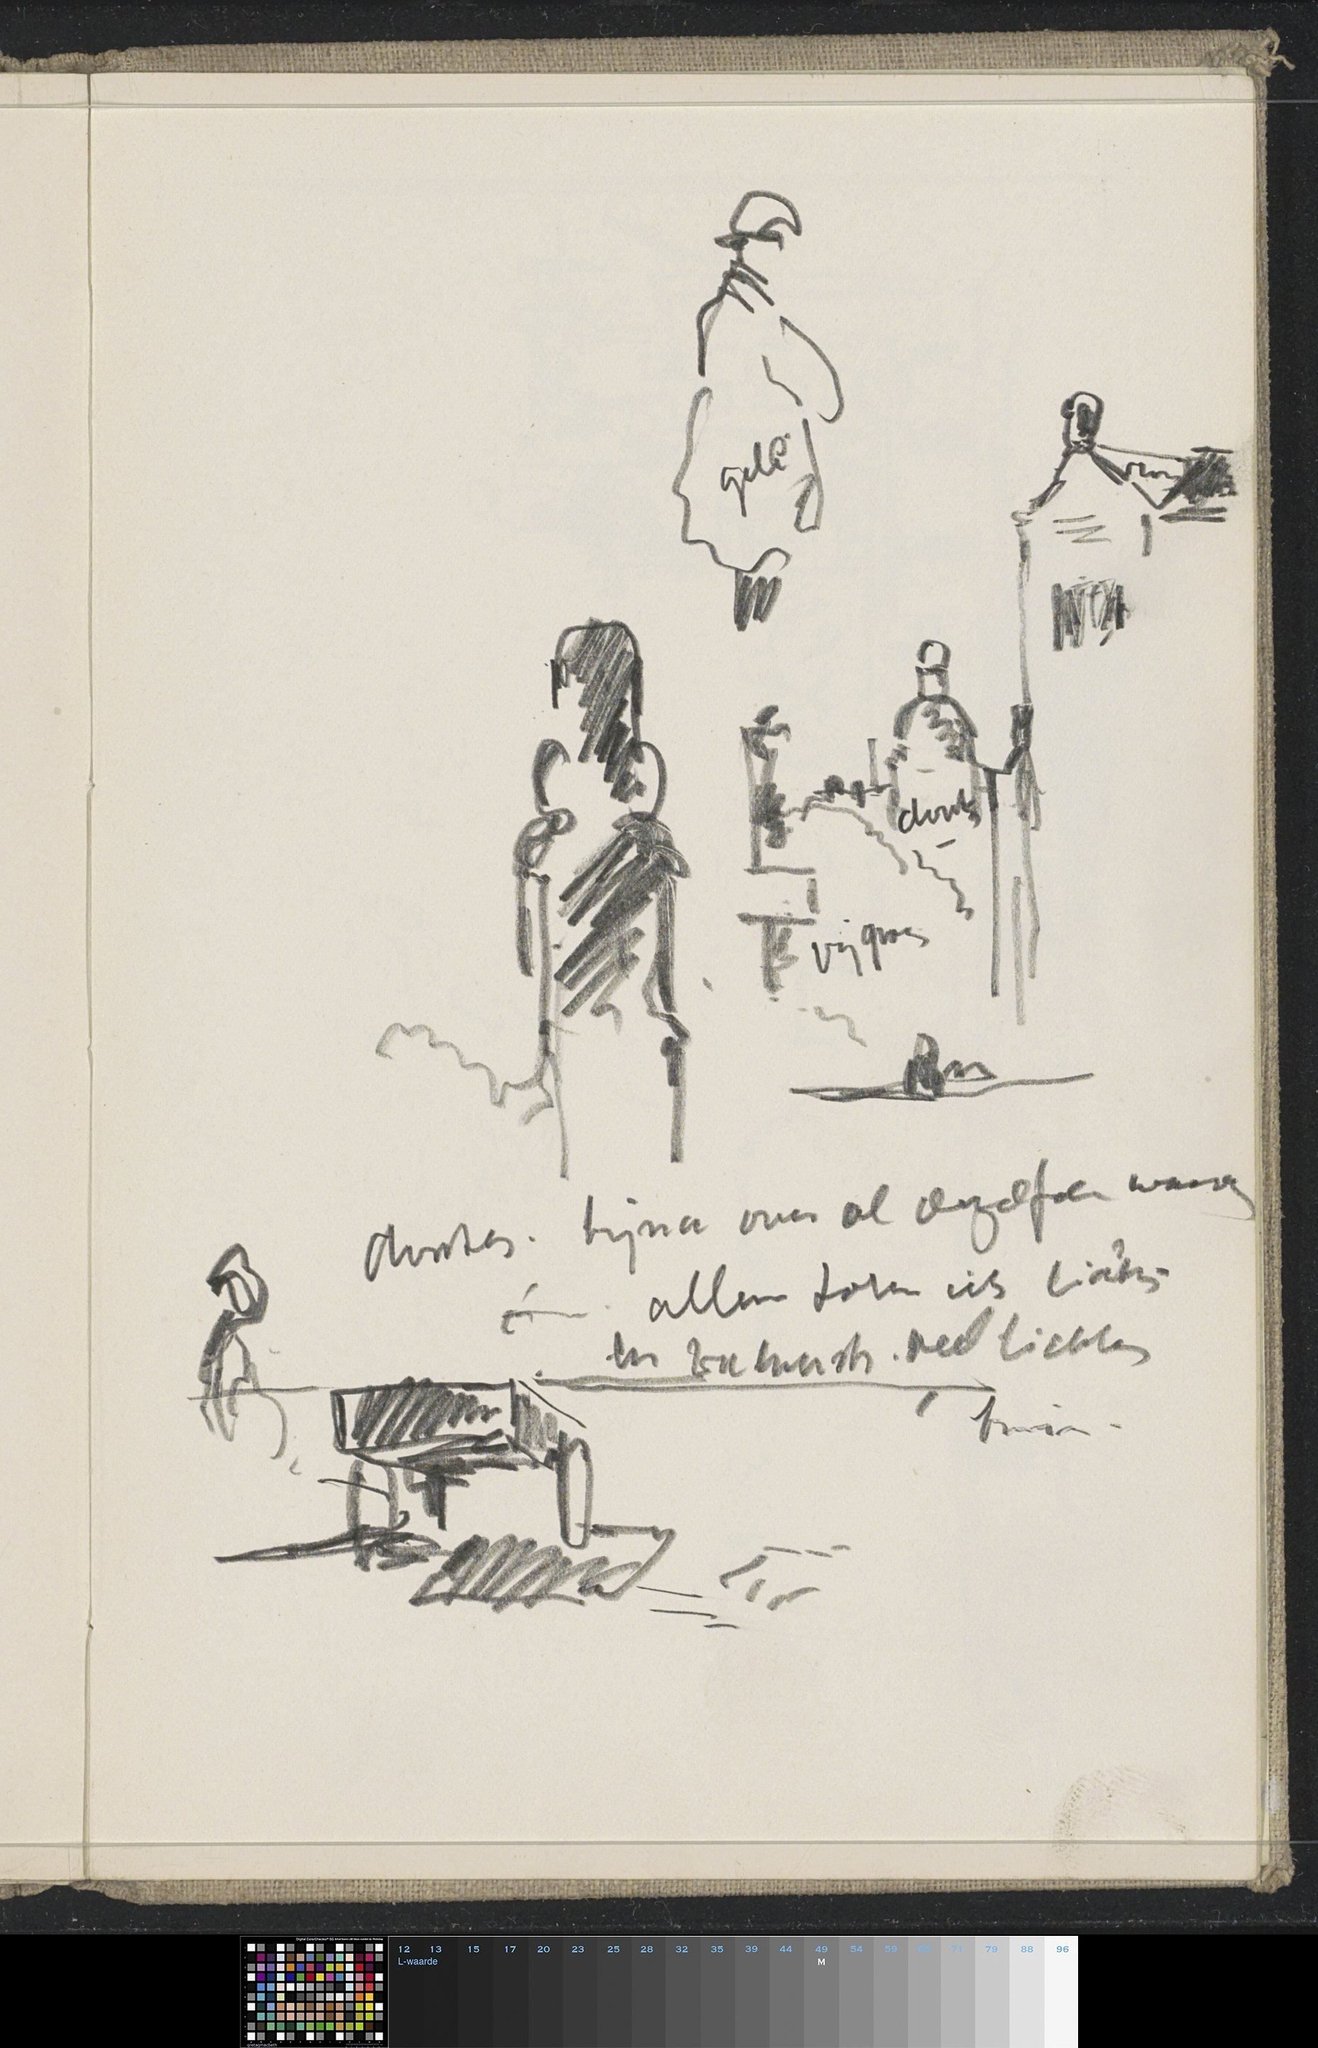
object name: sketchbook leaf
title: Stadsgezicht met een koepeltoren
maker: cornelis vreedenburgh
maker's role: draughtsman, print maker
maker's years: 1880-1946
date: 1890-1946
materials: paper, pencil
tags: city-view, and landscape with man-made constructions, dome ~ architecture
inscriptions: kleurnotitie, handgeschreven in potlood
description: Tevens een studie van een staande man met hoed. Blad 37 recto uit een schetsboek met 41 bladen.